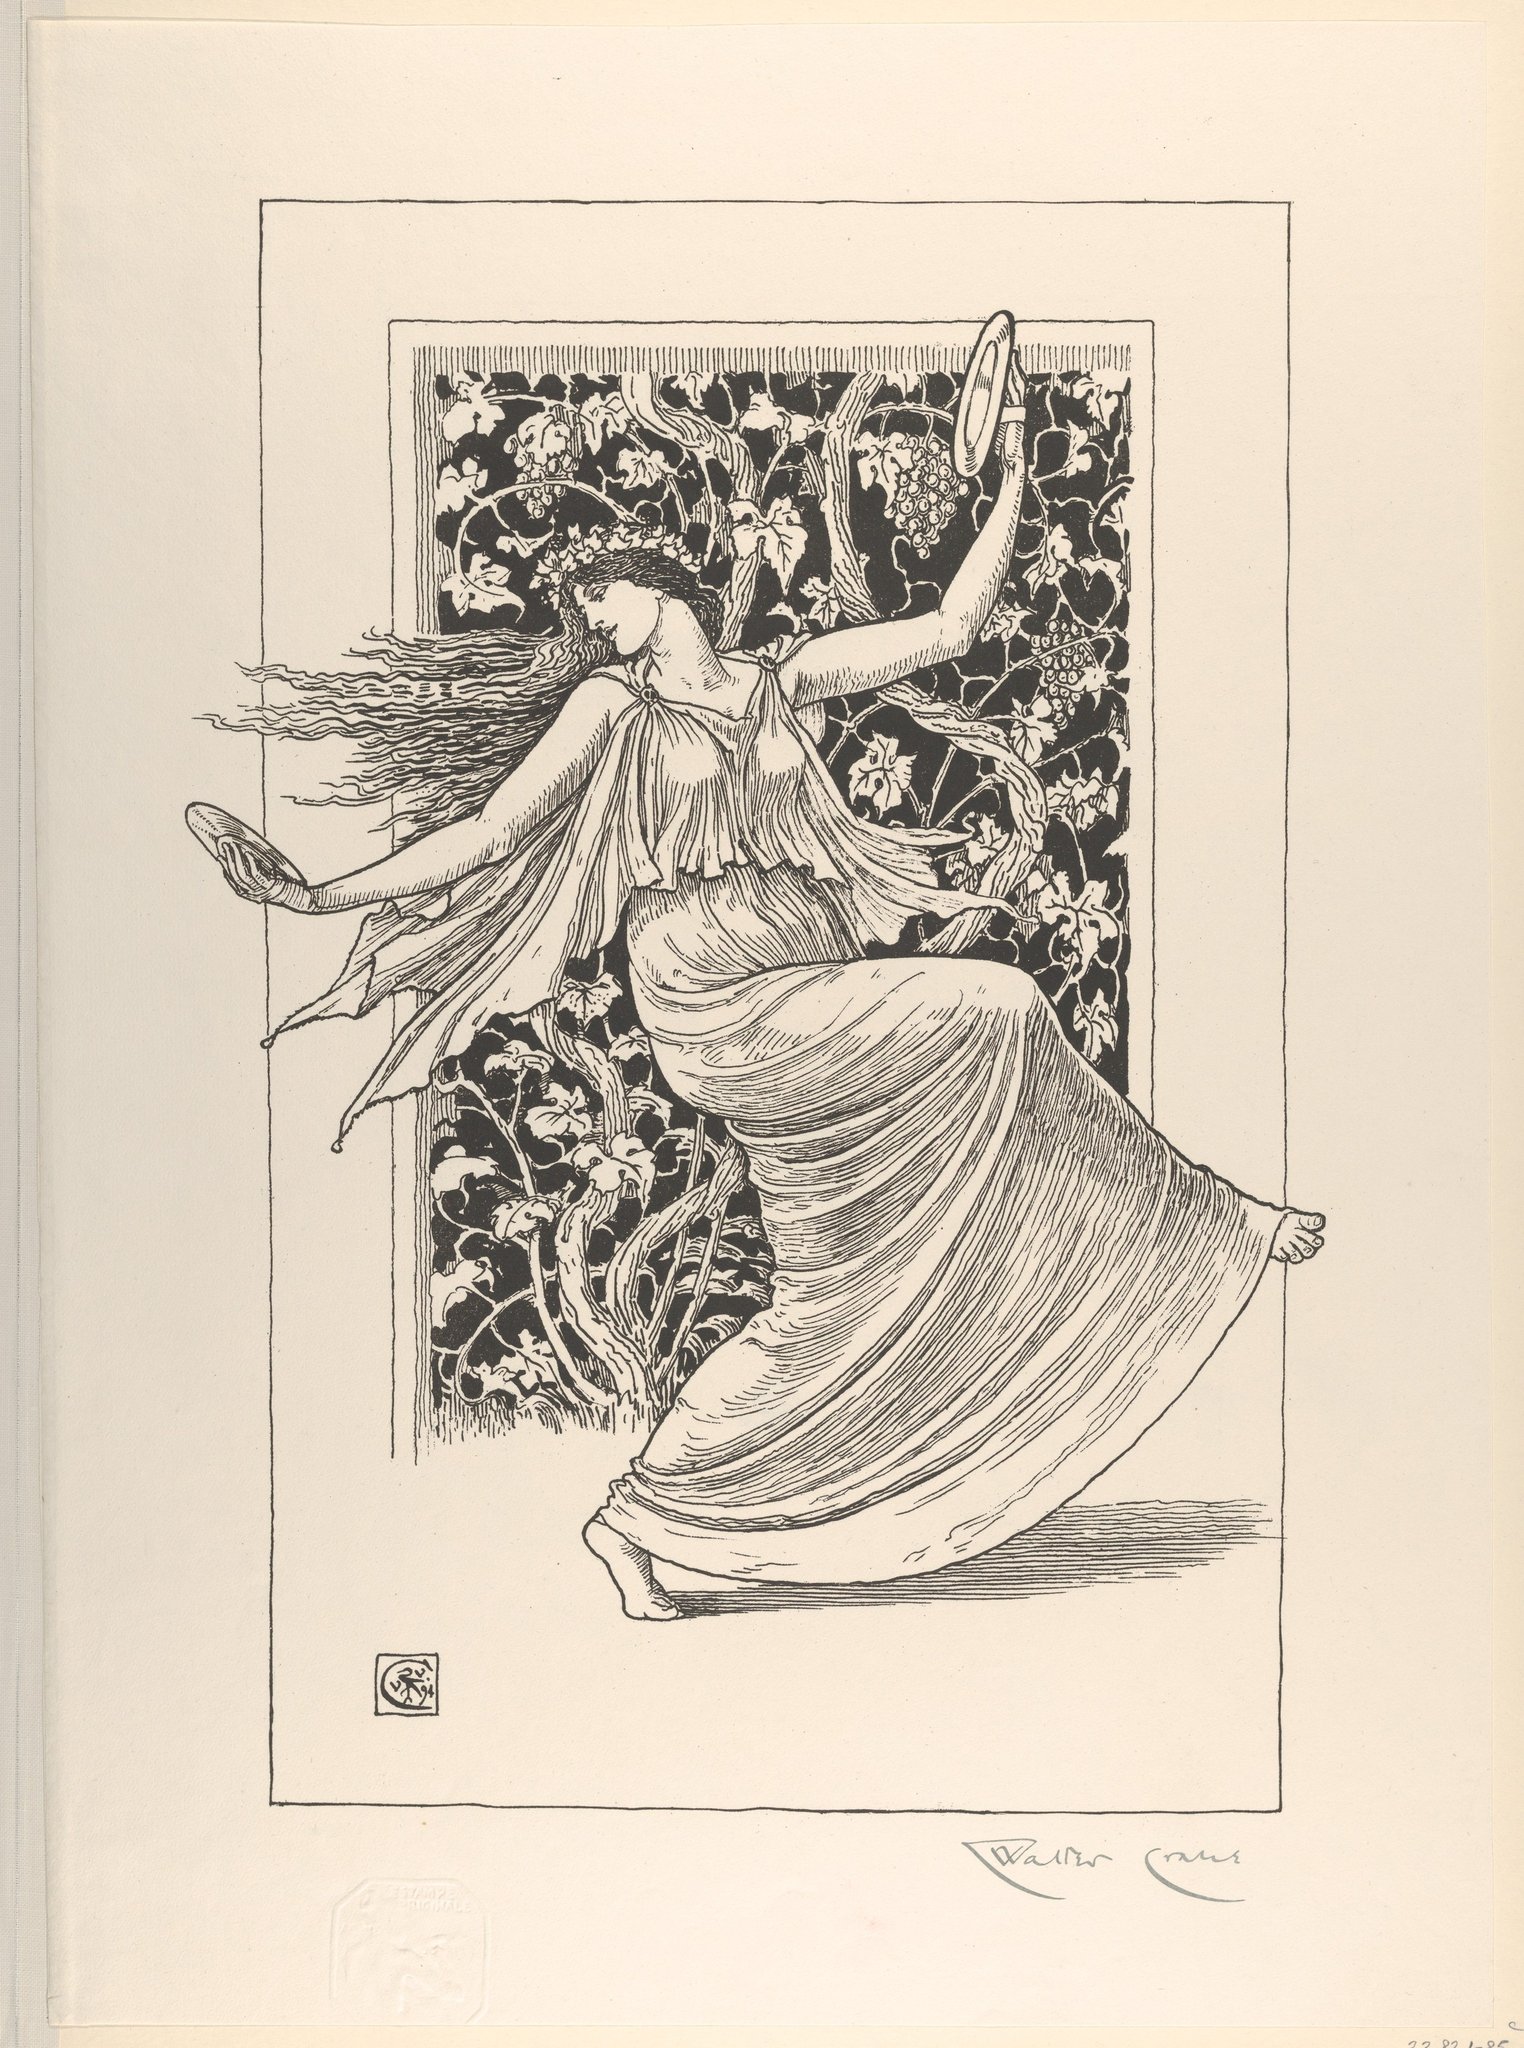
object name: print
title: Dancing Nymph (Nymphe Danseuse), from "L'Estampe Originale"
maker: walter crane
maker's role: artist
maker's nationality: british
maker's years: 1845-1915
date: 1895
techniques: lithograph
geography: france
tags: dancing,nymphs